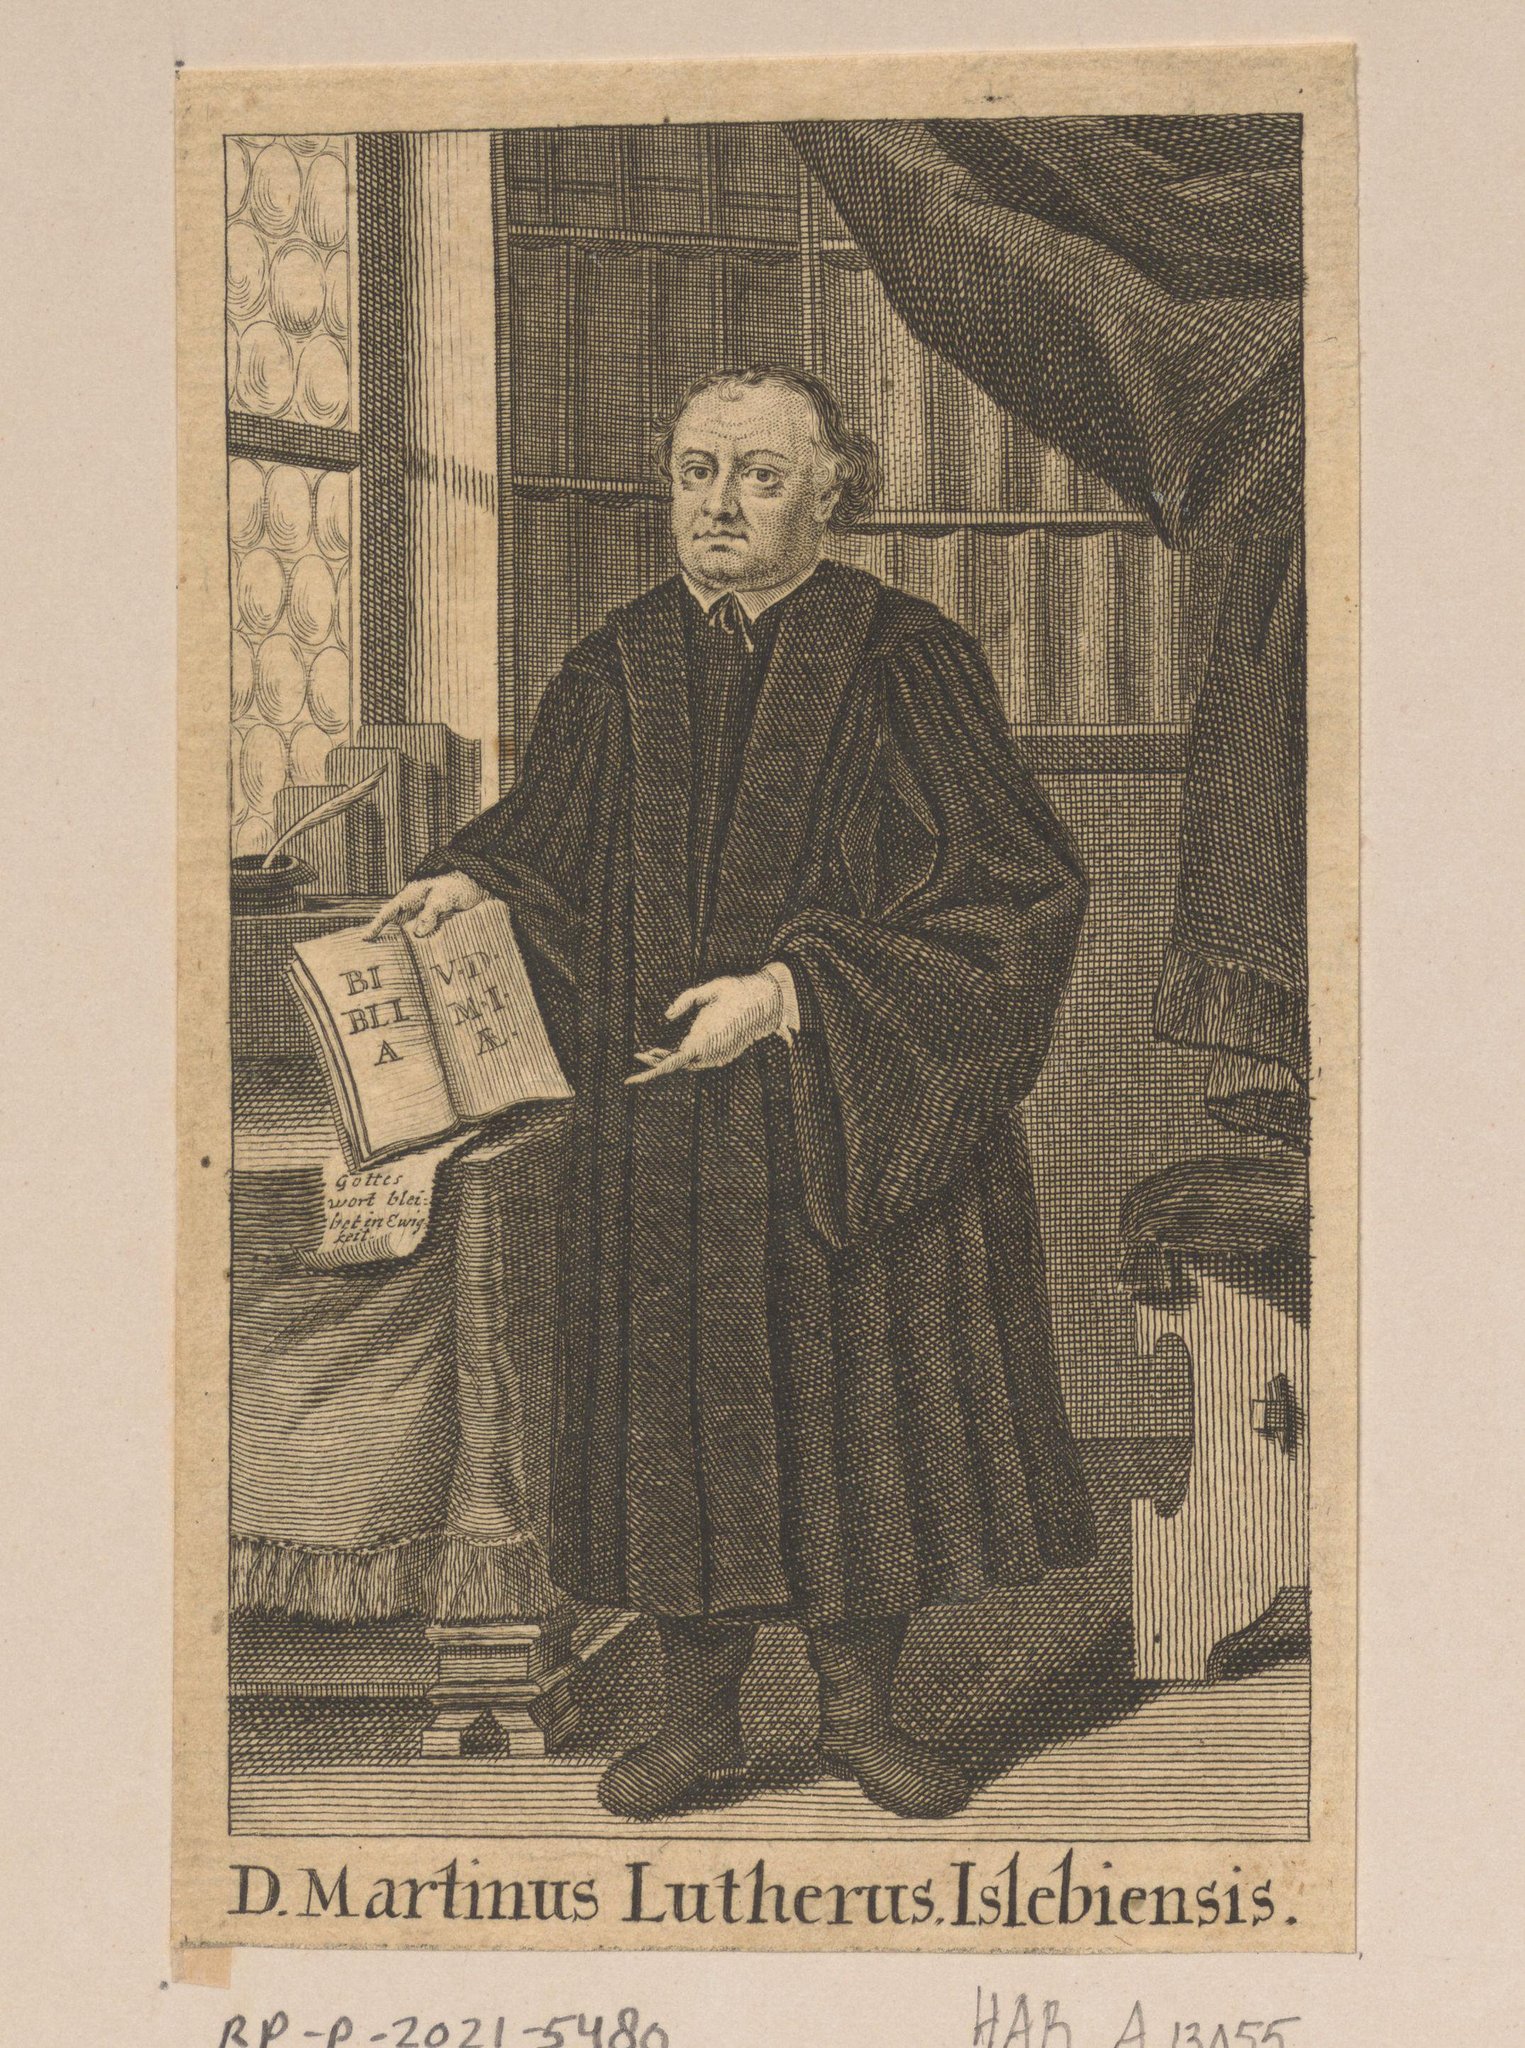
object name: book illustration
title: Portret van Martin Luther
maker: Anonymous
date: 1718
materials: paper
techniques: engraving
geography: germany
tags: martin luther, theologian, historical persons, study; 'studiolo'; library, the bible as a book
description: Prent waarschijnlijk uit: Tentzel, Wilhelm Ernst. Historischen Bericht vom Anfang un ersten Fortgang der Reformation Lutheri (...). Leipzig: Johann Ludwig Gleditsch en Moritz Georg Weidmann, 1718.